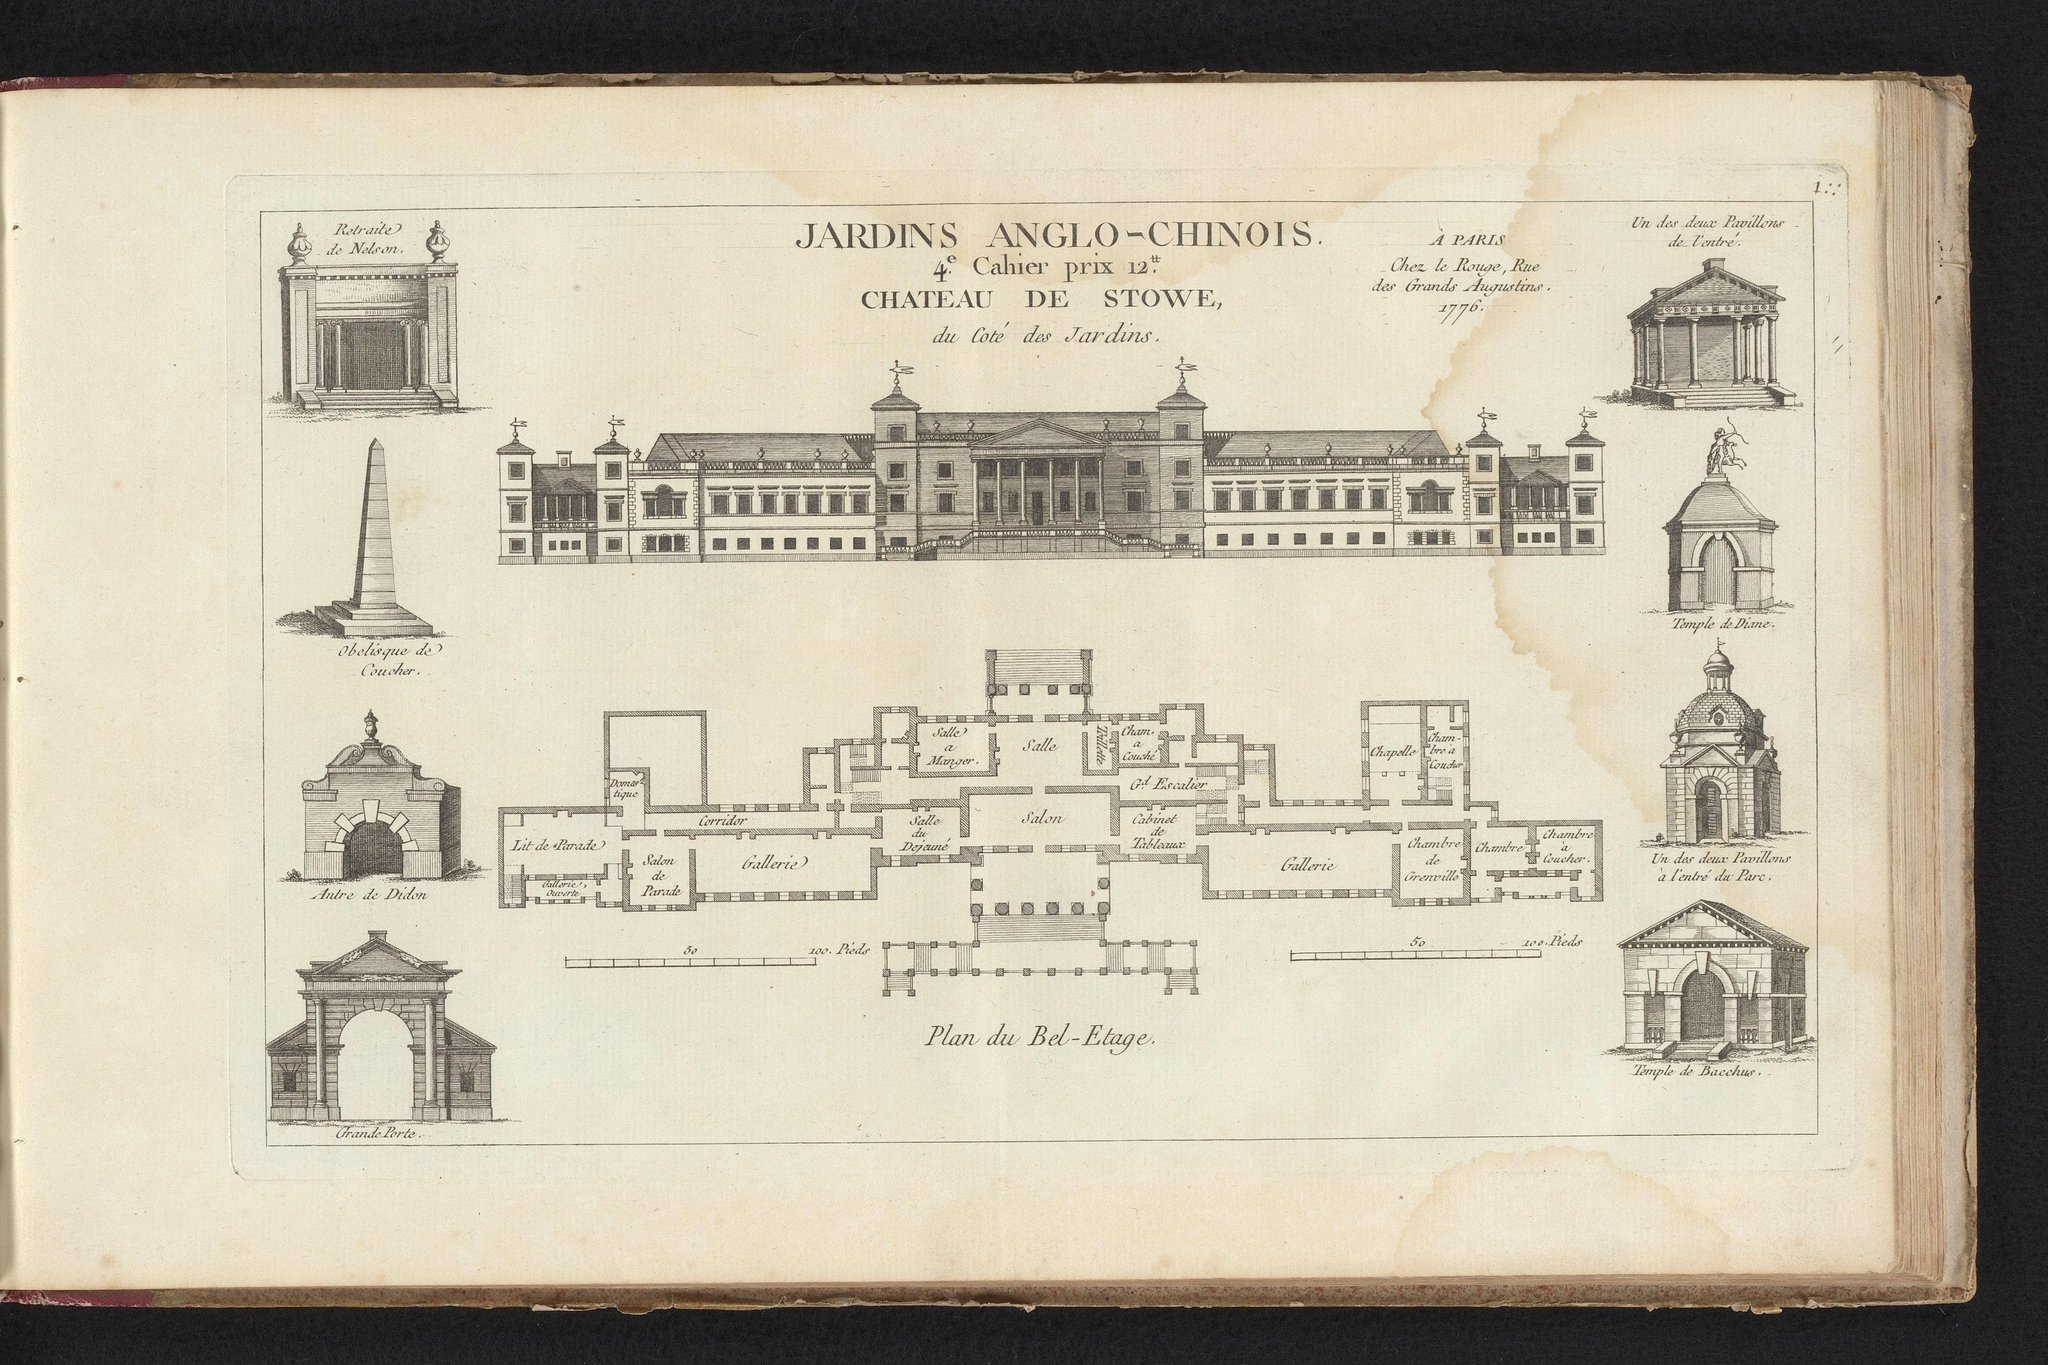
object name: print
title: Jardins Anglo-Chinois 4e cahier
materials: paper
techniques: engraving, etching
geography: paris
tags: obelisks (garden ornaments), castle, garden buildings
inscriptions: collector's mark: Lugt 2760, collector's mark: Lugt 2228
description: De serie 'Jardins anglo-chinois à la mode' verscheen in totaal in 21 zogeheten 'cahiers' (afleveringen). De huidige prent komt uit het vierde 'cahier'. Het Rijksmuseum Amsterdam bezit drie banden met daarin in totaal zes 'cahiers' van deze reeks. In de documentatie wordt verwezen naar een in de bibliotheek van het Rijksmuseum Amsterdam aanwezige facsimile van het complete werk.